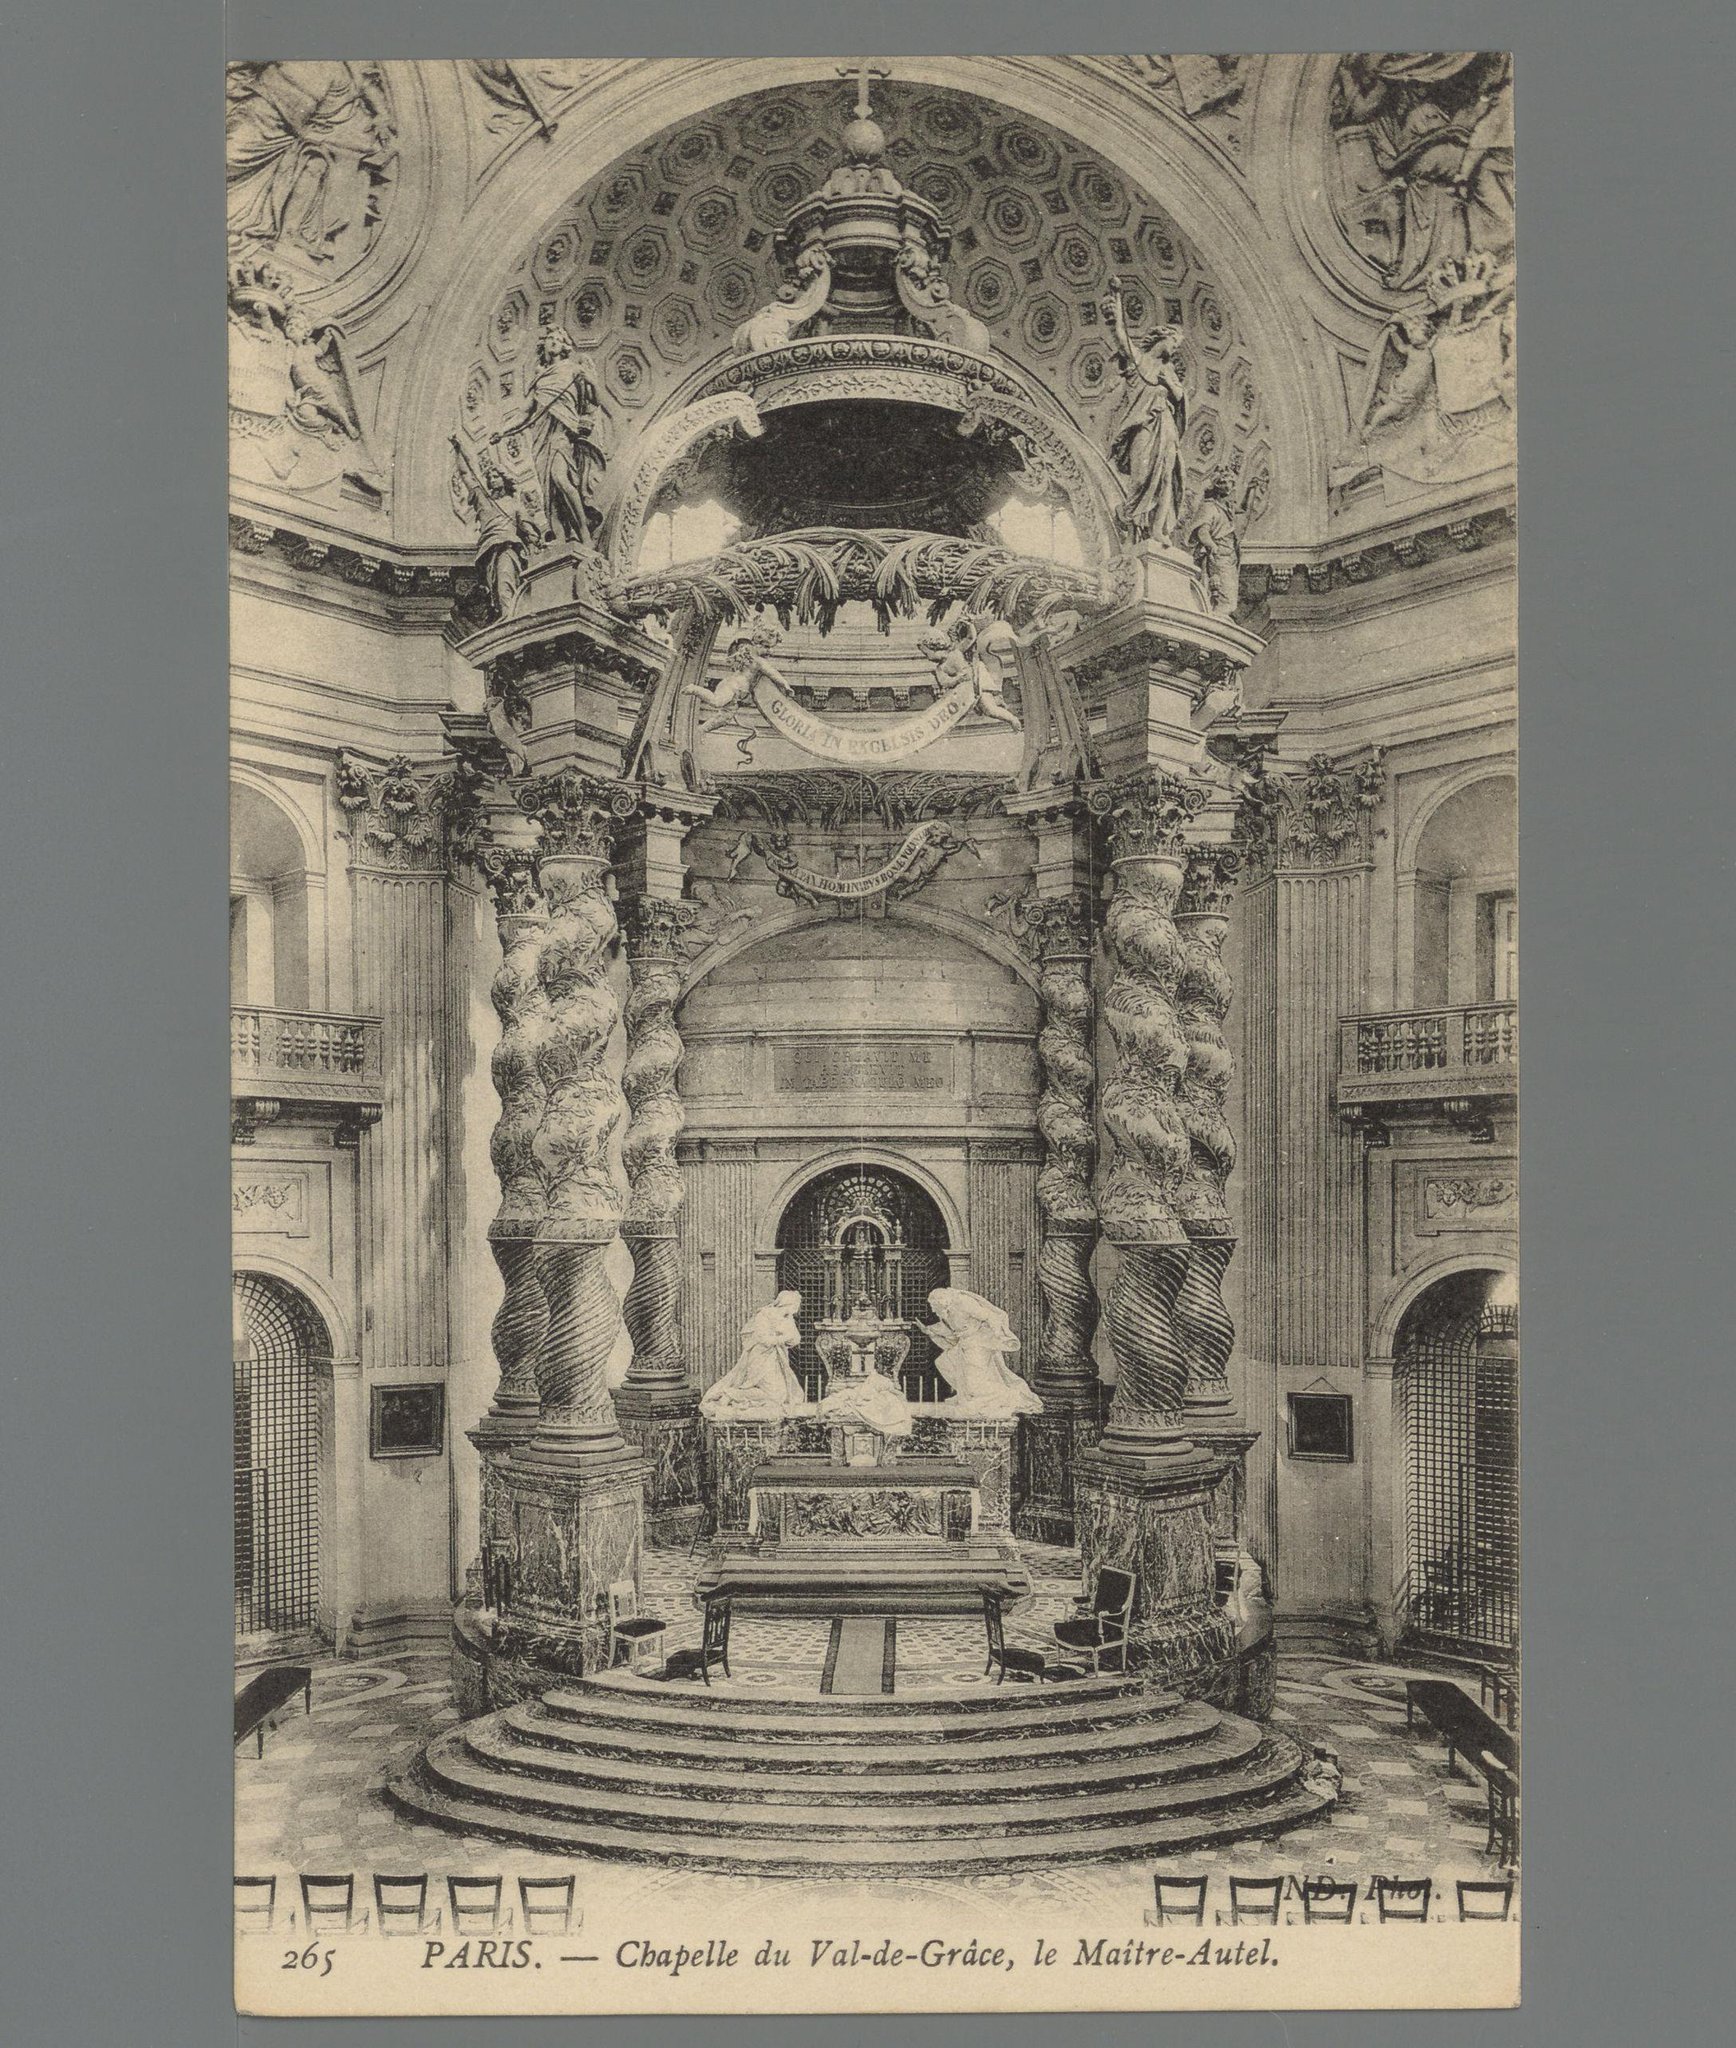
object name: photomechanical print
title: Paris. Chapelle du Val-de Grâce, le Maître-Autel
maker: Anonymous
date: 1904-1906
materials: cardboard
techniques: photograph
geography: paris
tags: interior of church, altar, paris